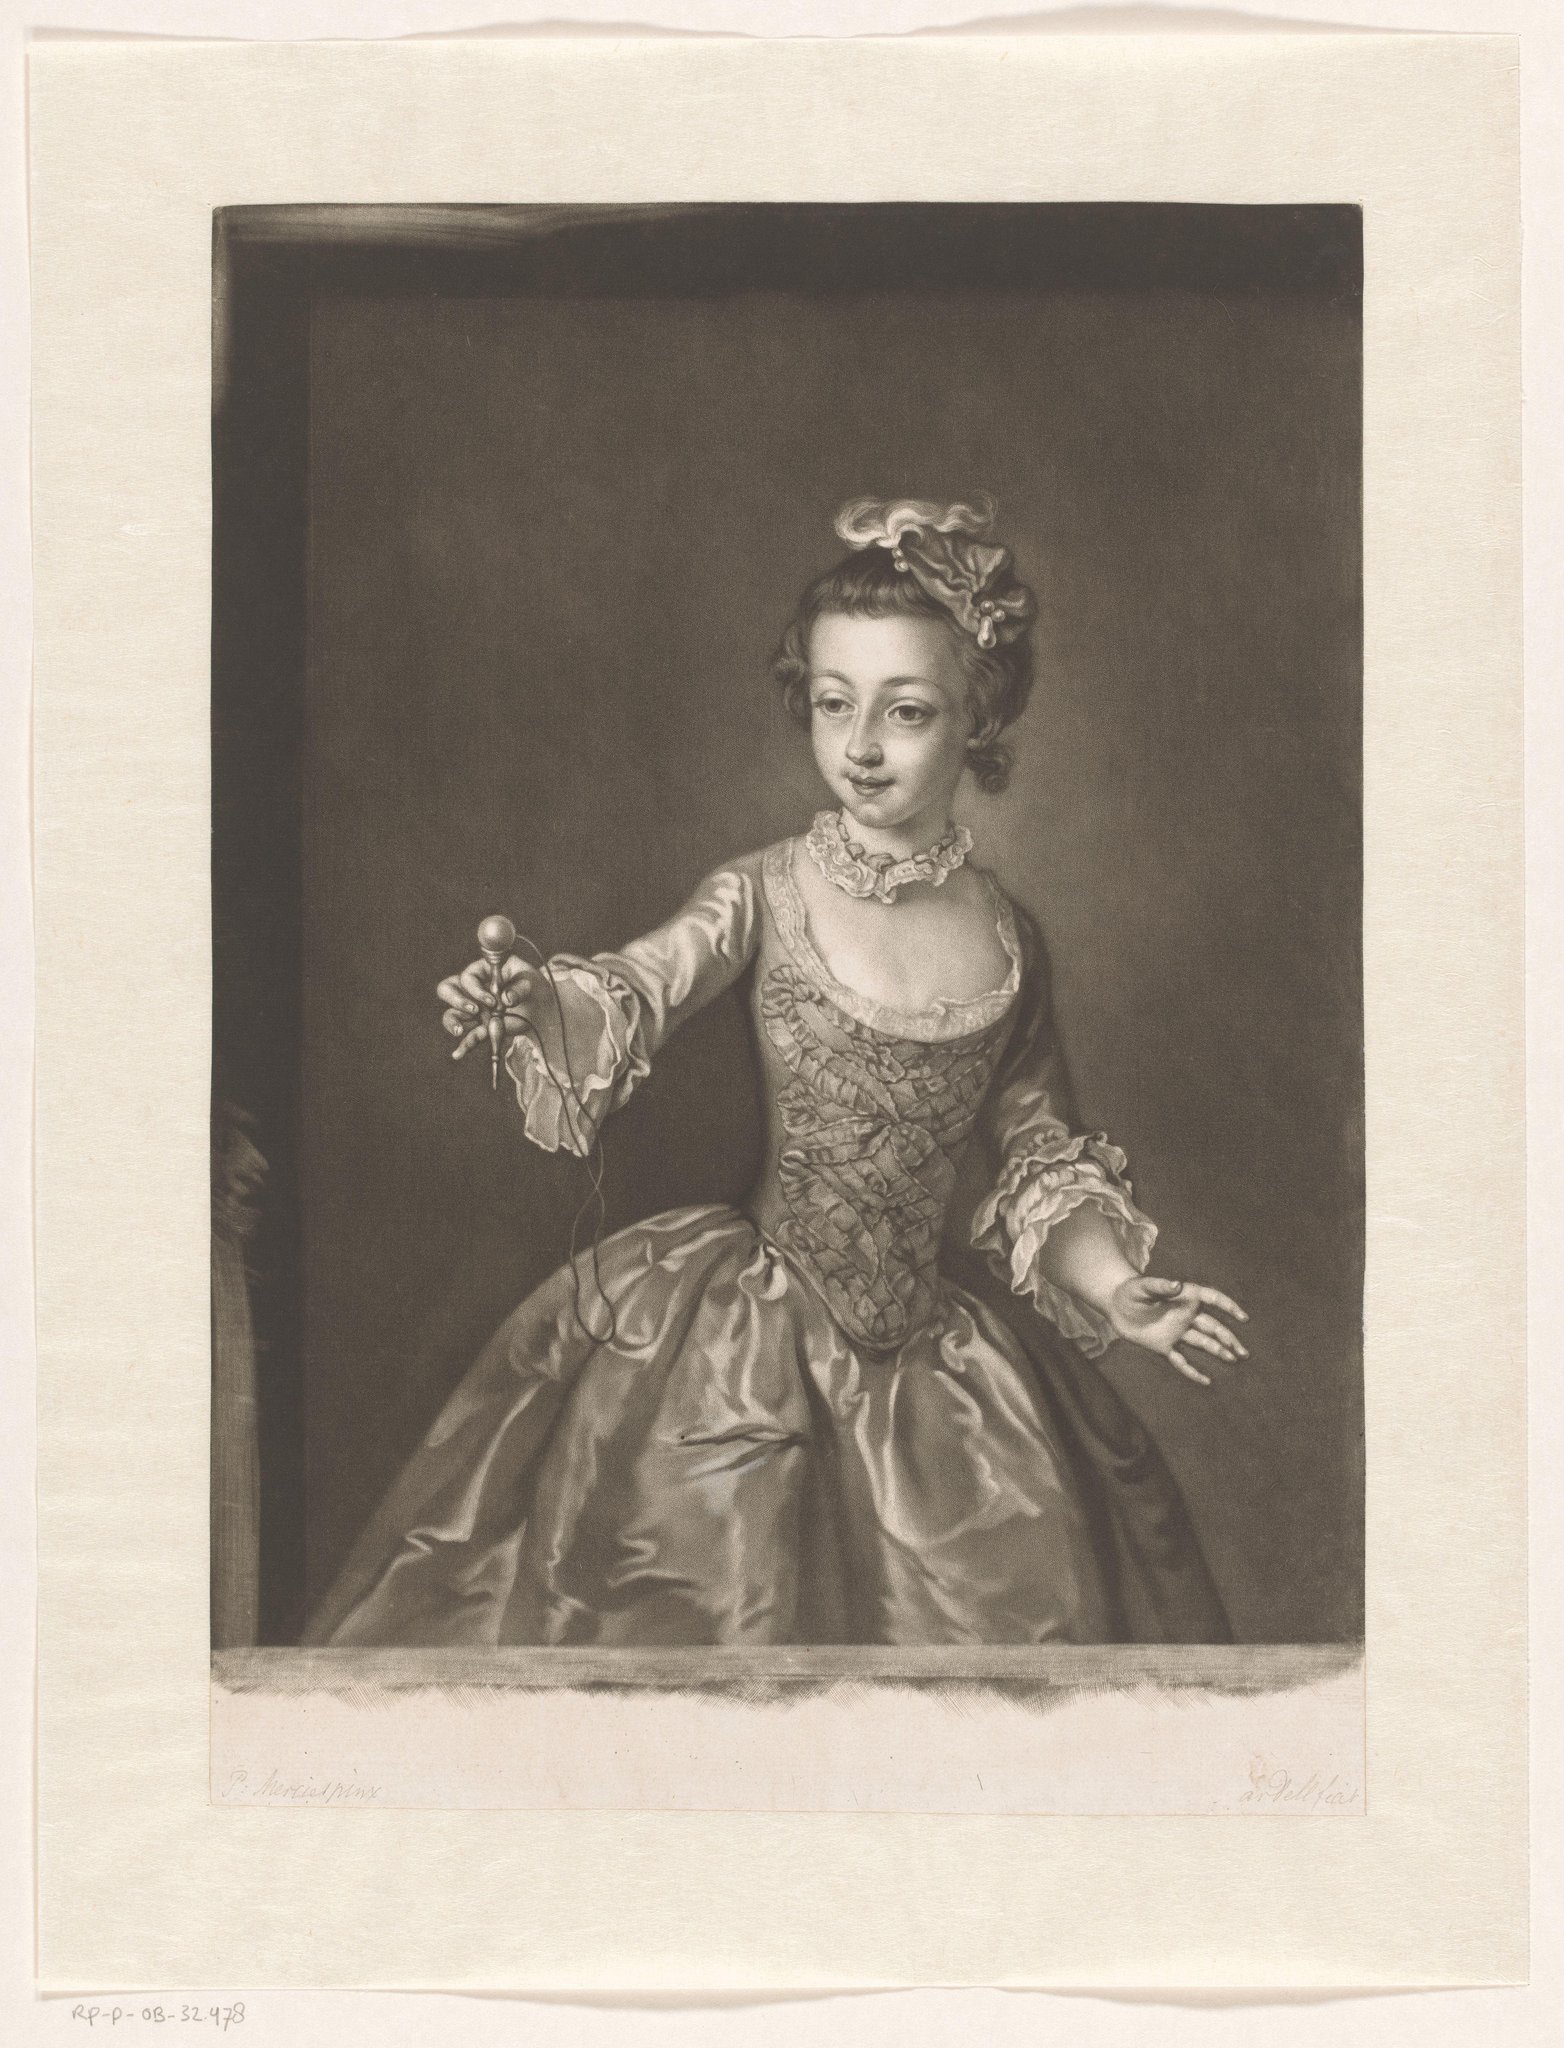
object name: print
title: Portret van een meisje met bilboquet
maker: james mcardell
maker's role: print maker, publisher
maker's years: 1728-1765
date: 1756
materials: paper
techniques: mezzotint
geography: london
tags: charlotte mercier, cup-and-ball, bilboquet, anonymous historical person portrayed alone - bb - woman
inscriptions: collector's mark: Lugt 240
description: Chaloner Smith beschrijft dit als een portret van Charlotte Mercier.